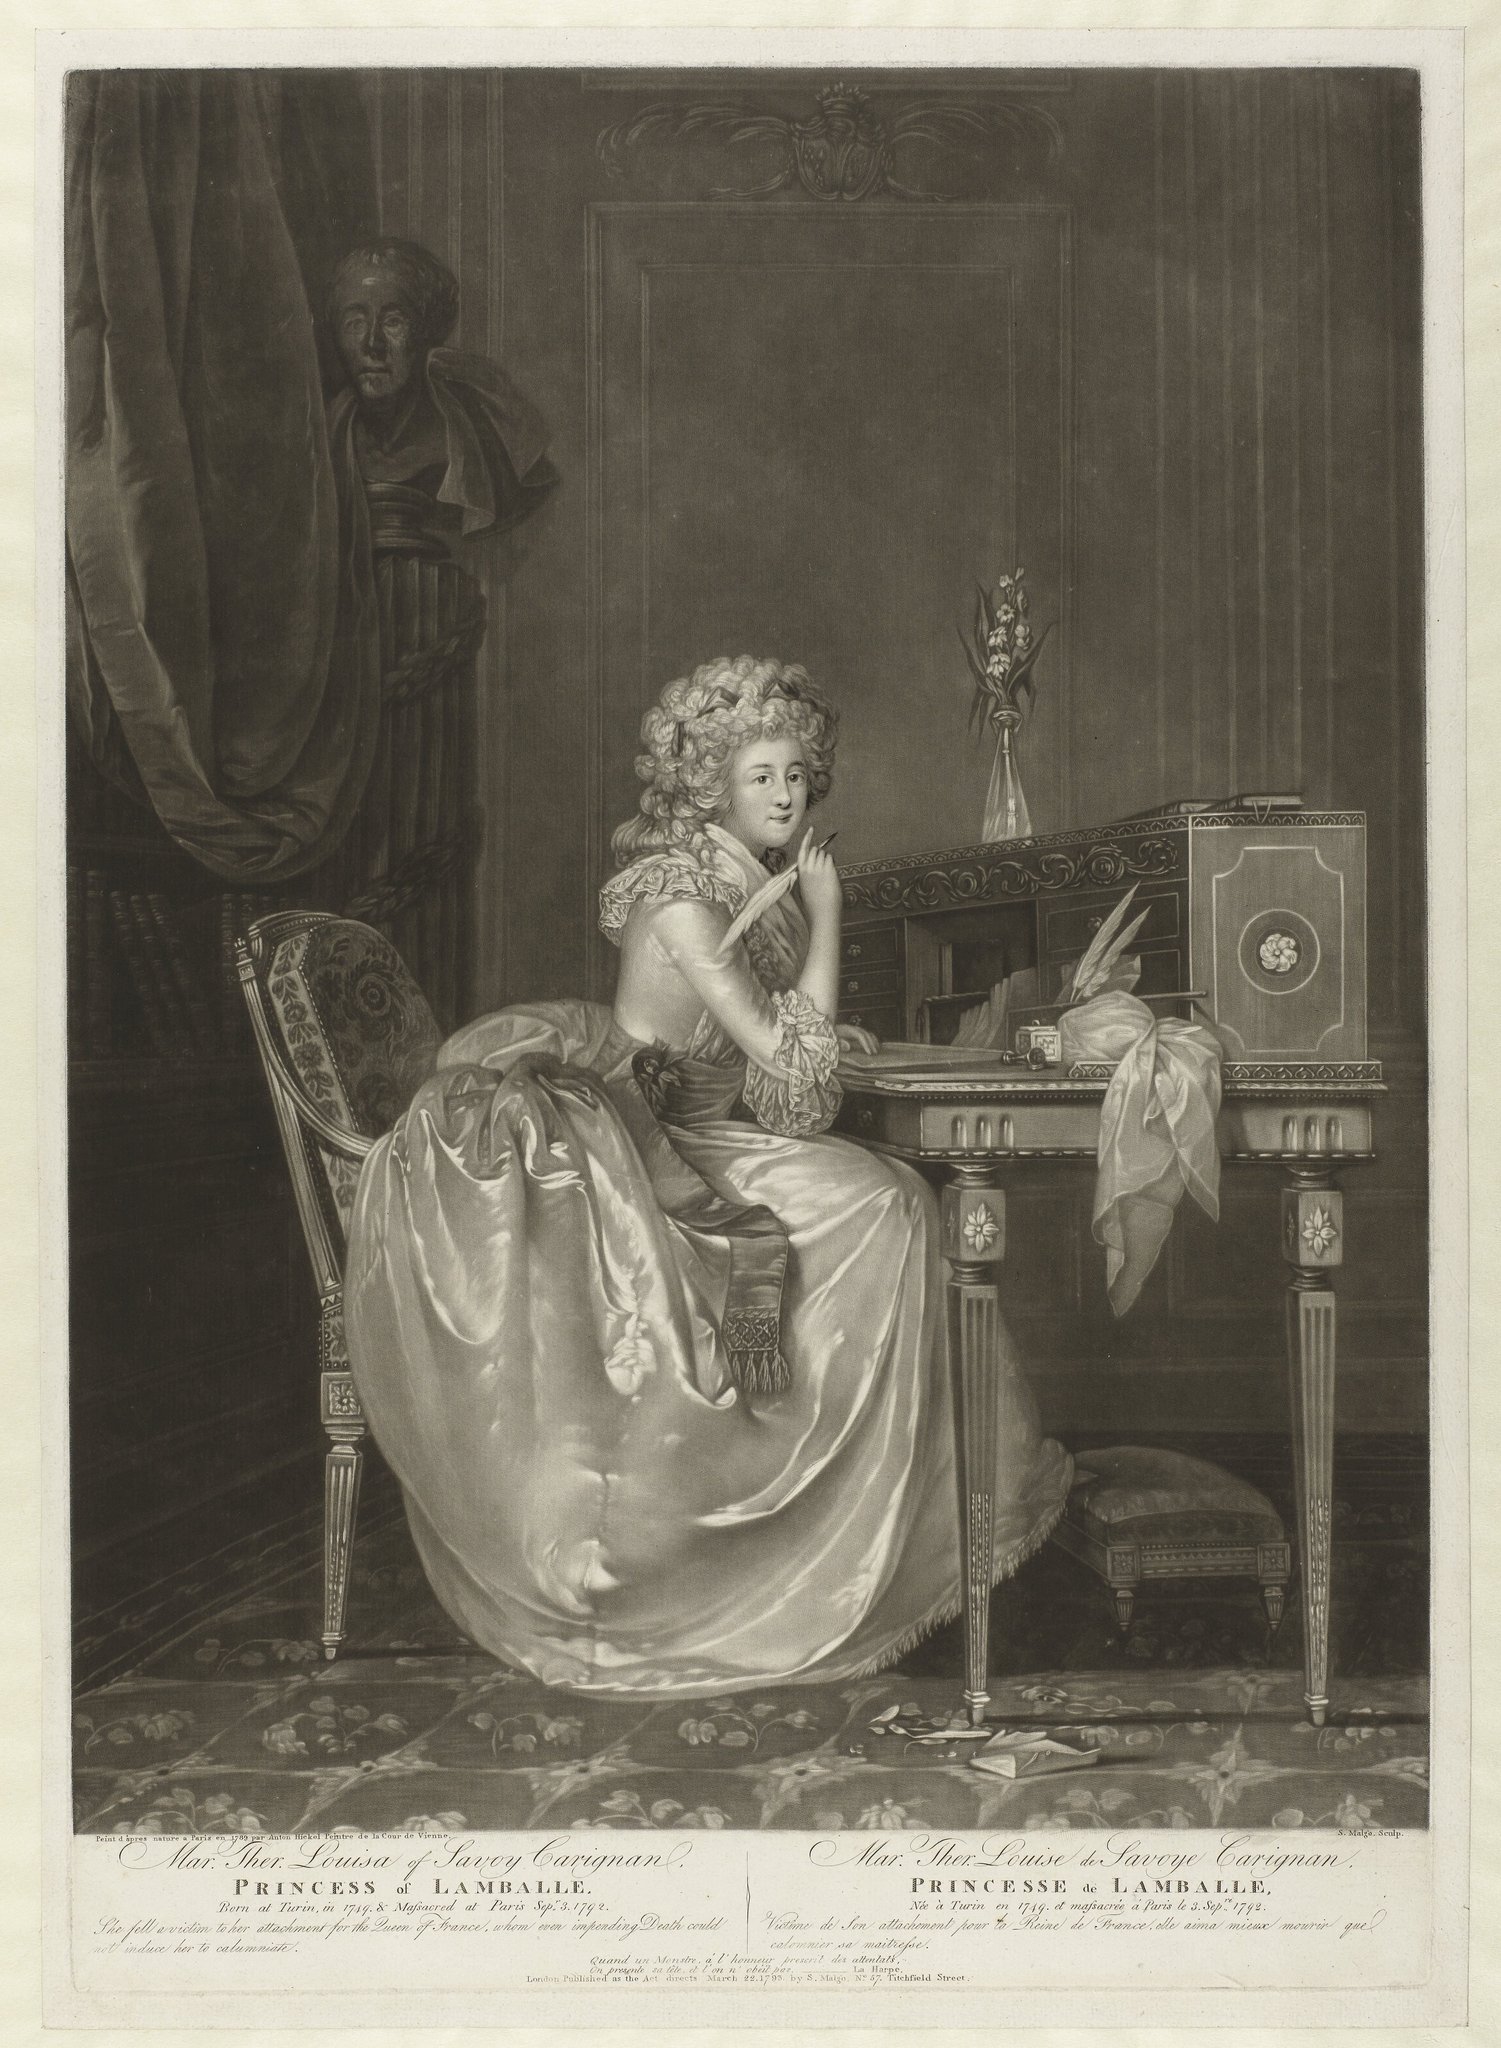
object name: print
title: Princess of Lamballe / Princesse de Lamballe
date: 1789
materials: paper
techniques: mezzotint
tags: paris, writing-table, writing-desk, historical persons, princess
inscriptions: collector's mark: Lugt 12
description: Tekst in het Engels en het Frans in de ondermarge.